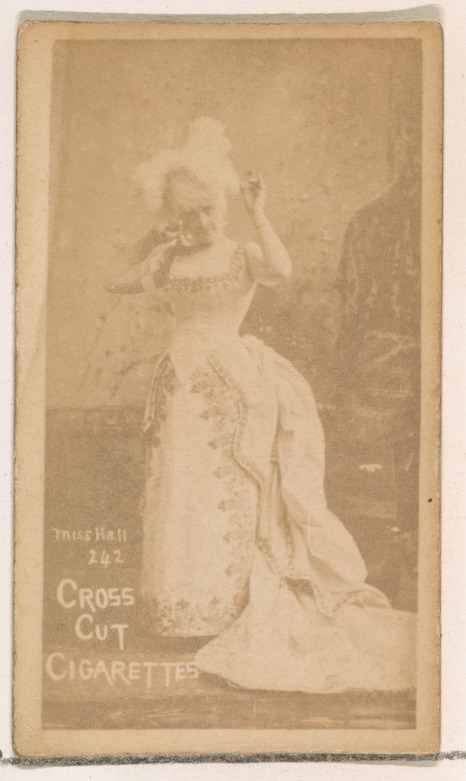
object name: print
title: Card Number 242, Miss Hall, from the Actors and Actresses series (N145-1) issued by Duke Sons & Co. to promote Cross Cut Cigarettes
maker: w. duke, sons & co.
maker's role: publisher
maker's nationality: american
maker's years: 1870-1920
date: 1880-1889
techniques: albumen silver print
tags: portraits,women,actresses